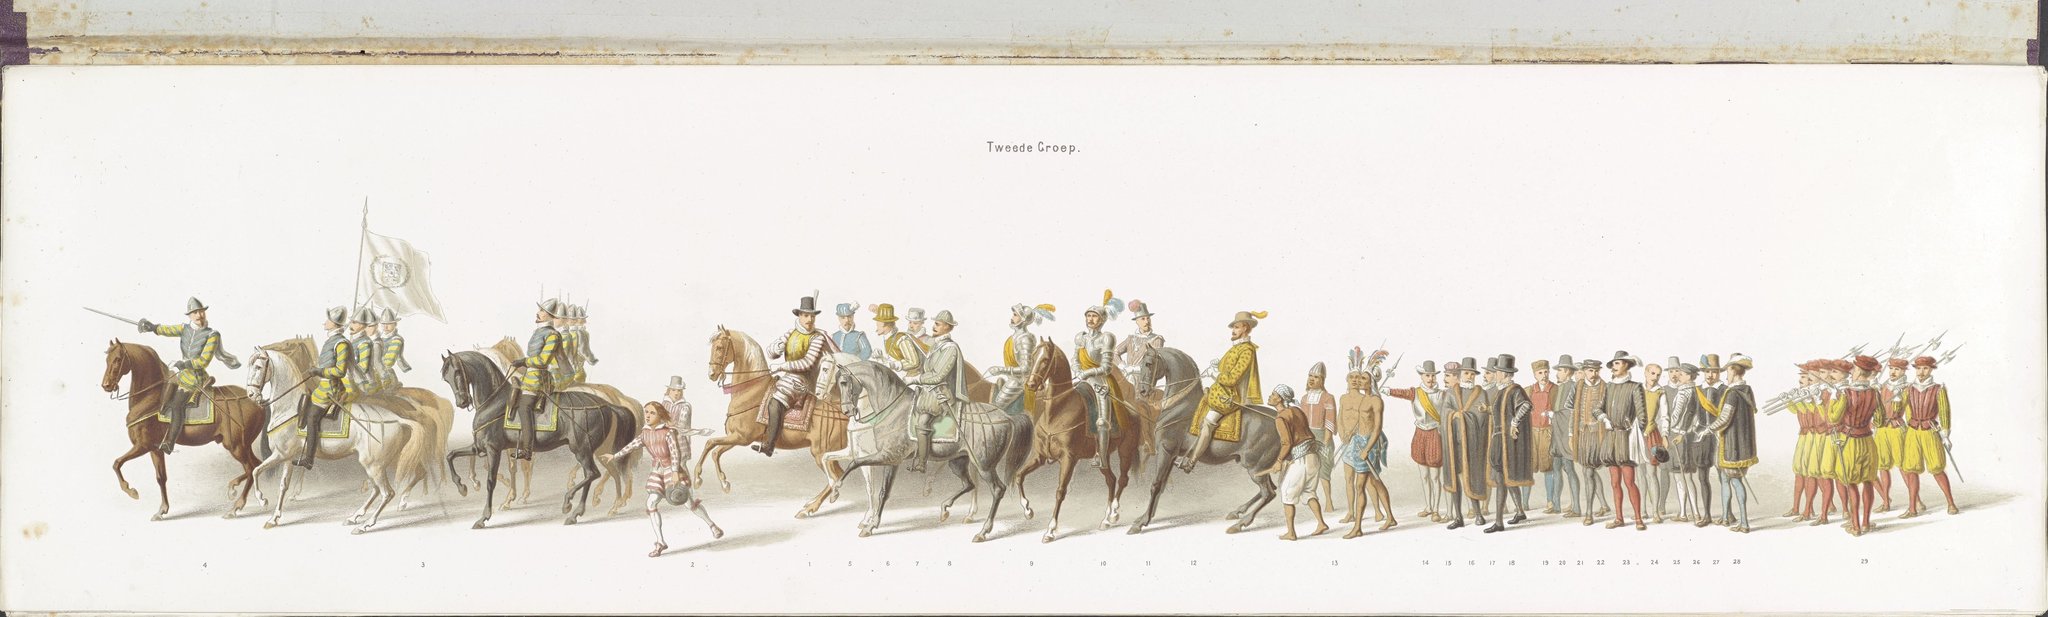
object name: print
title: Gecostumeerde Historische Optocht bij de viering van het 25-jarig regeerings-jubilé van Z:M: Willem III Koning der Nederlanden. 12 Mei 1874. Gehouden te Amsterdam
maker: Anonymous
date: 1874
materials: paper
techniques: chromolithography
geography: netherlands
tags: brussels, willem iii (koning der nederlanden), festivities on events of national importance (+ parade, pageant, cavalcade ~ festive activities), costumes used in pageants, amsterdam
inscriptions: collector's mark: Lugt 2228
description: Tweede van de zeven Oranjegroepen, de figuren genummerd 1-29. Onderdeel van de groep van negen platen van de gekostumeerde historische optocht gehouden te Amsterdam bij de viering van het 25-jarig regeringsjubileum van koning Willem III op 12 mei 1874.